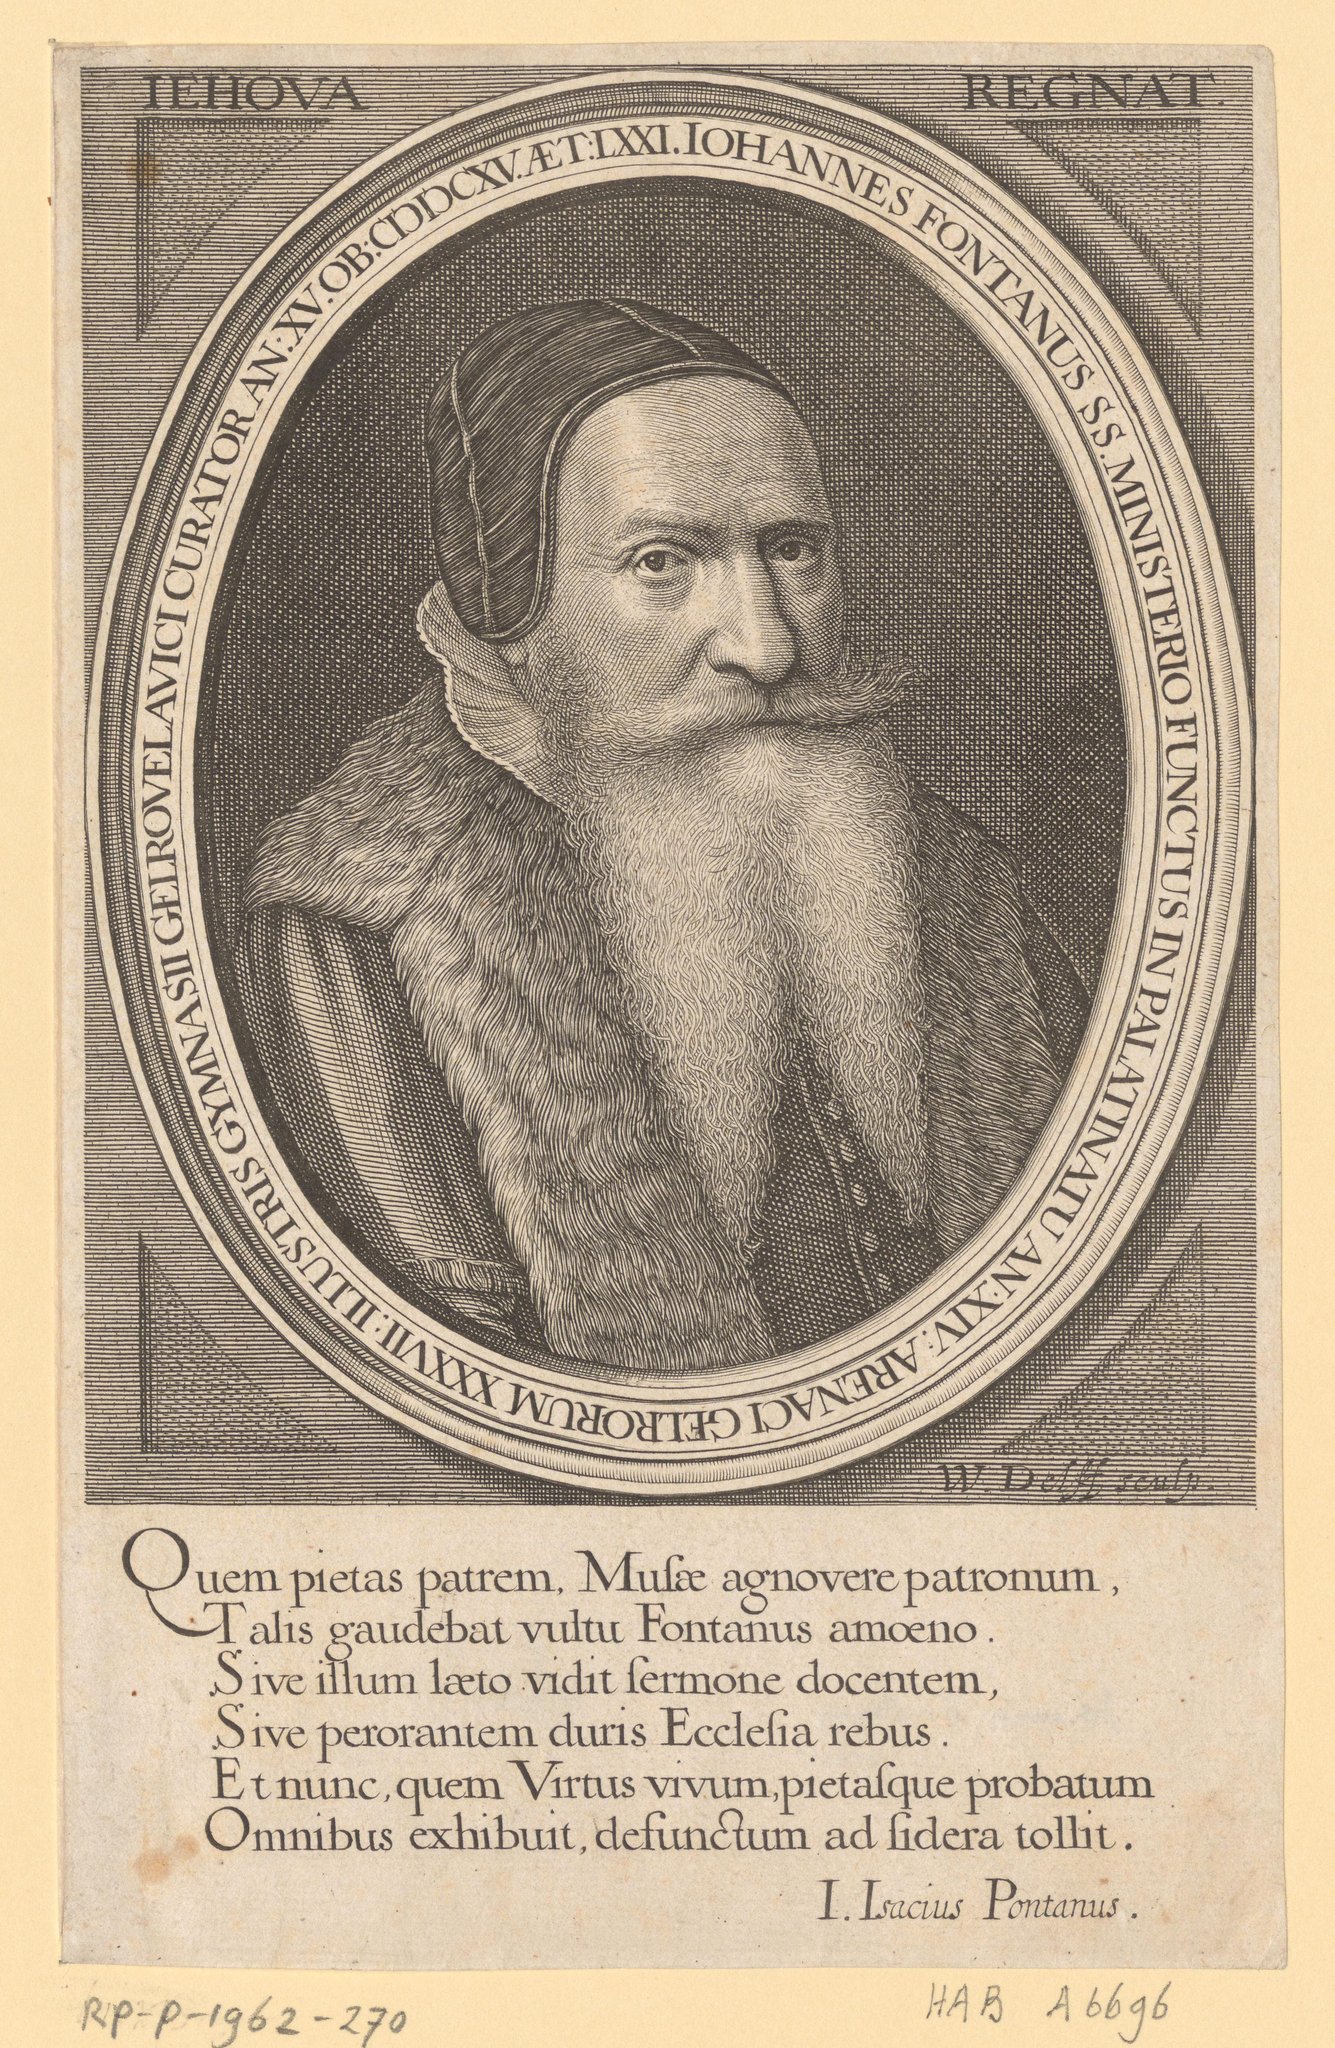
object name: print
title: Portret van Johannes Fontanus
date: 1615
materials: paper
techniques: engraving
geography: delft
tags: theologian, historical persons